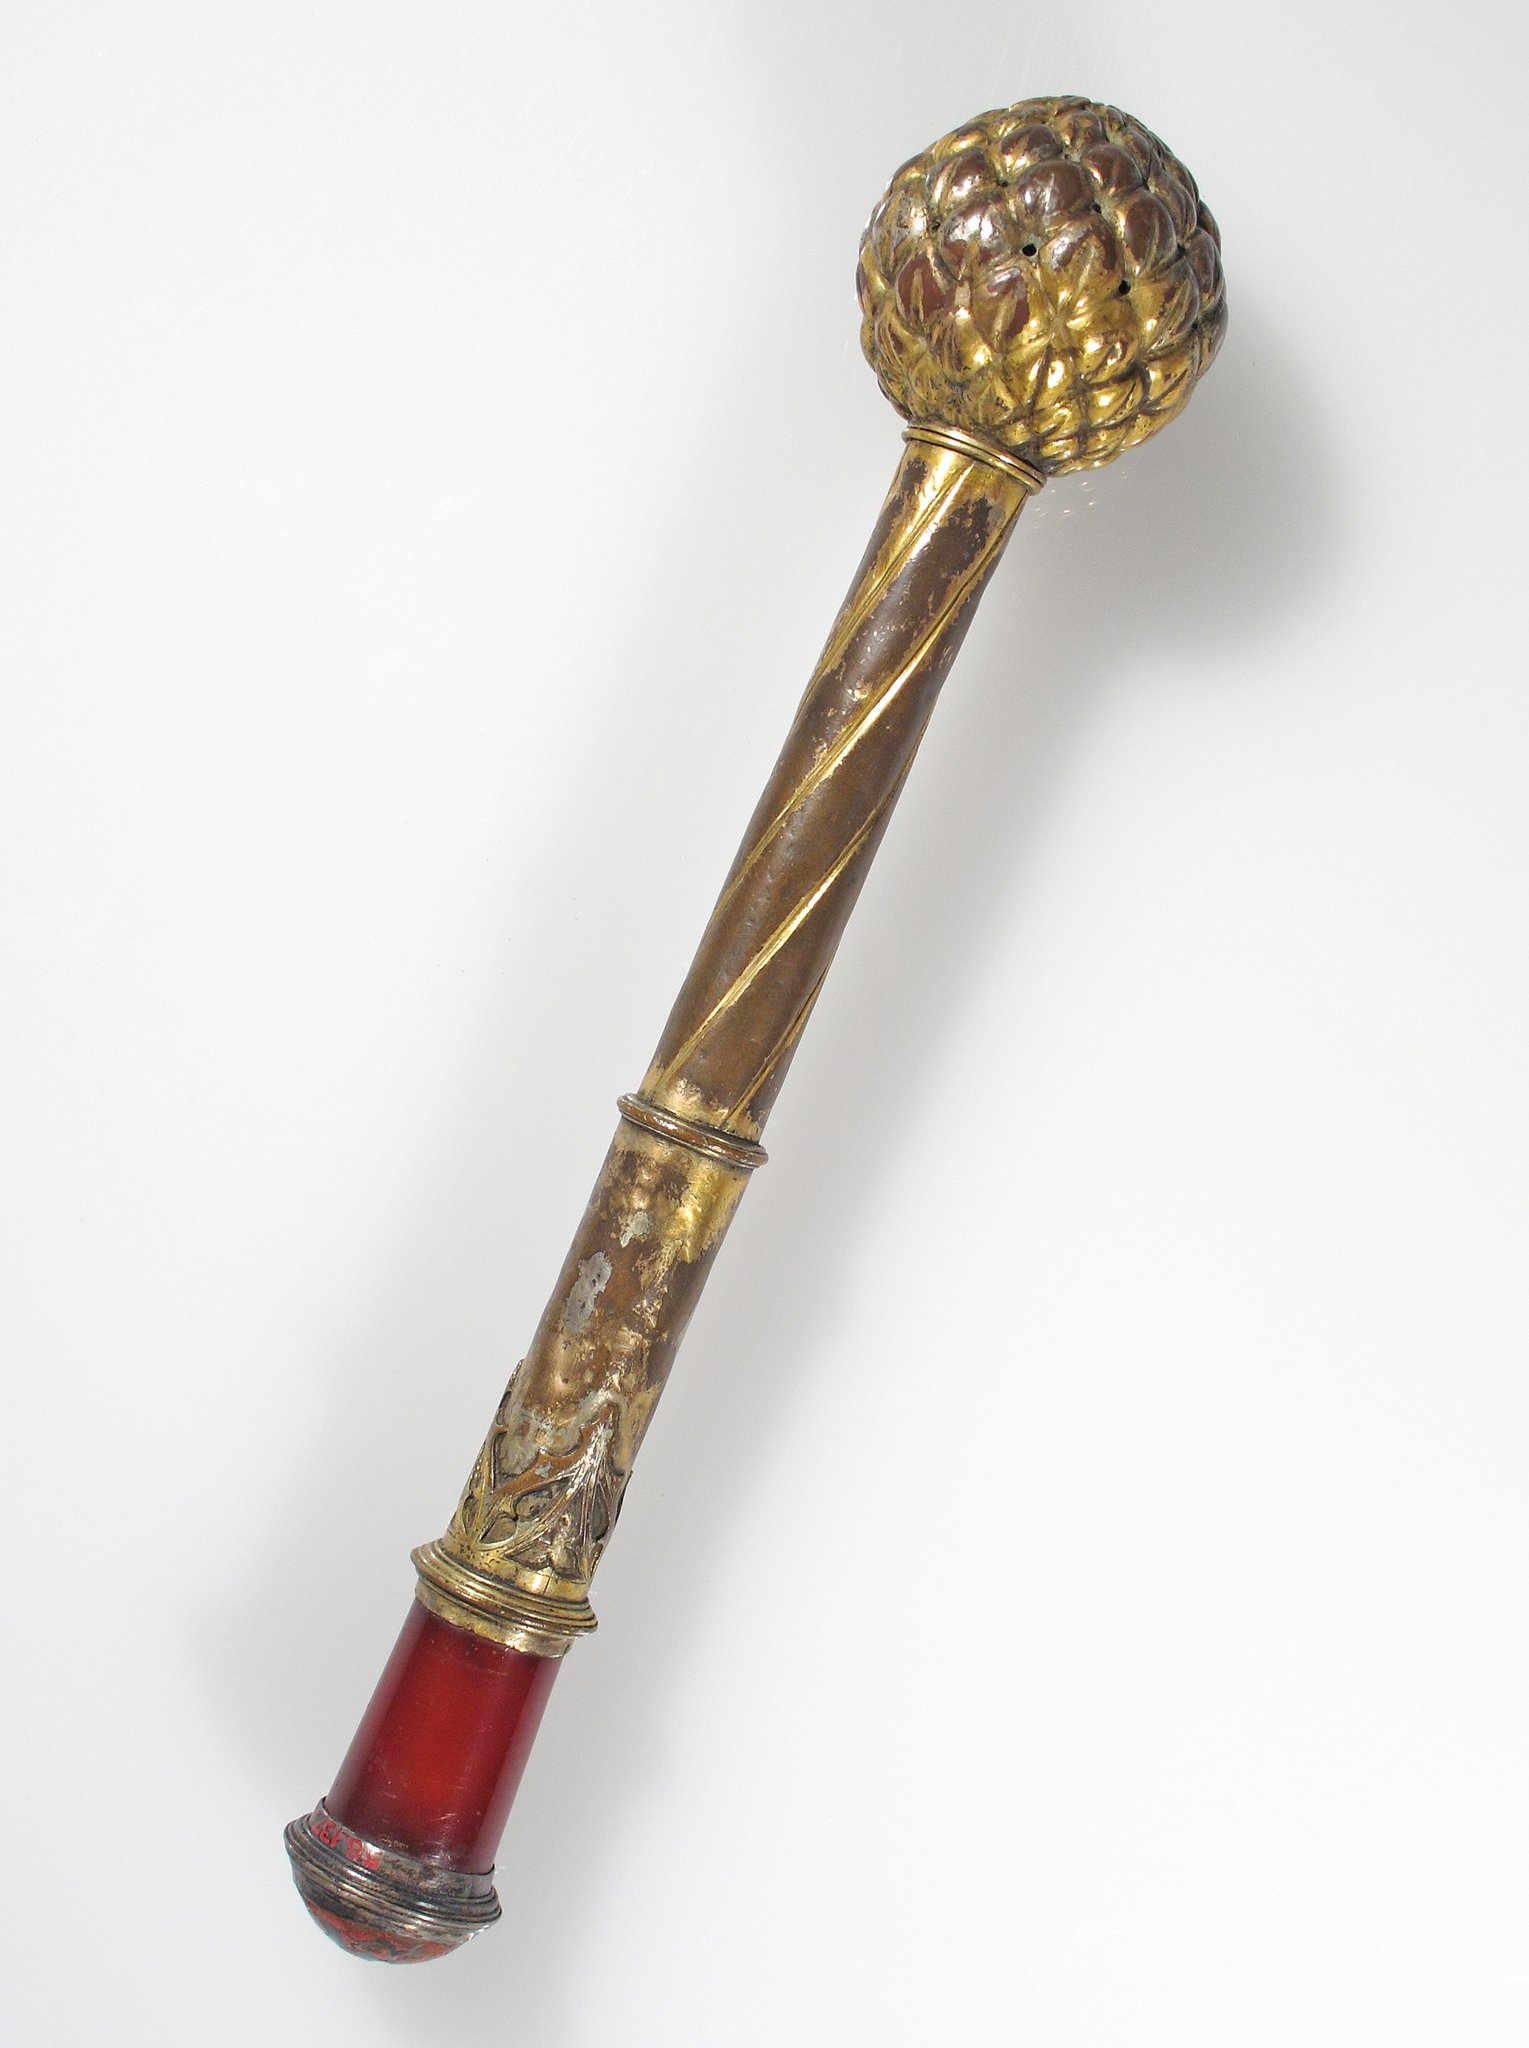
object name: asperges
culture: french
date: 1401-1500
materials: amber, gilt copper, enamel, silver